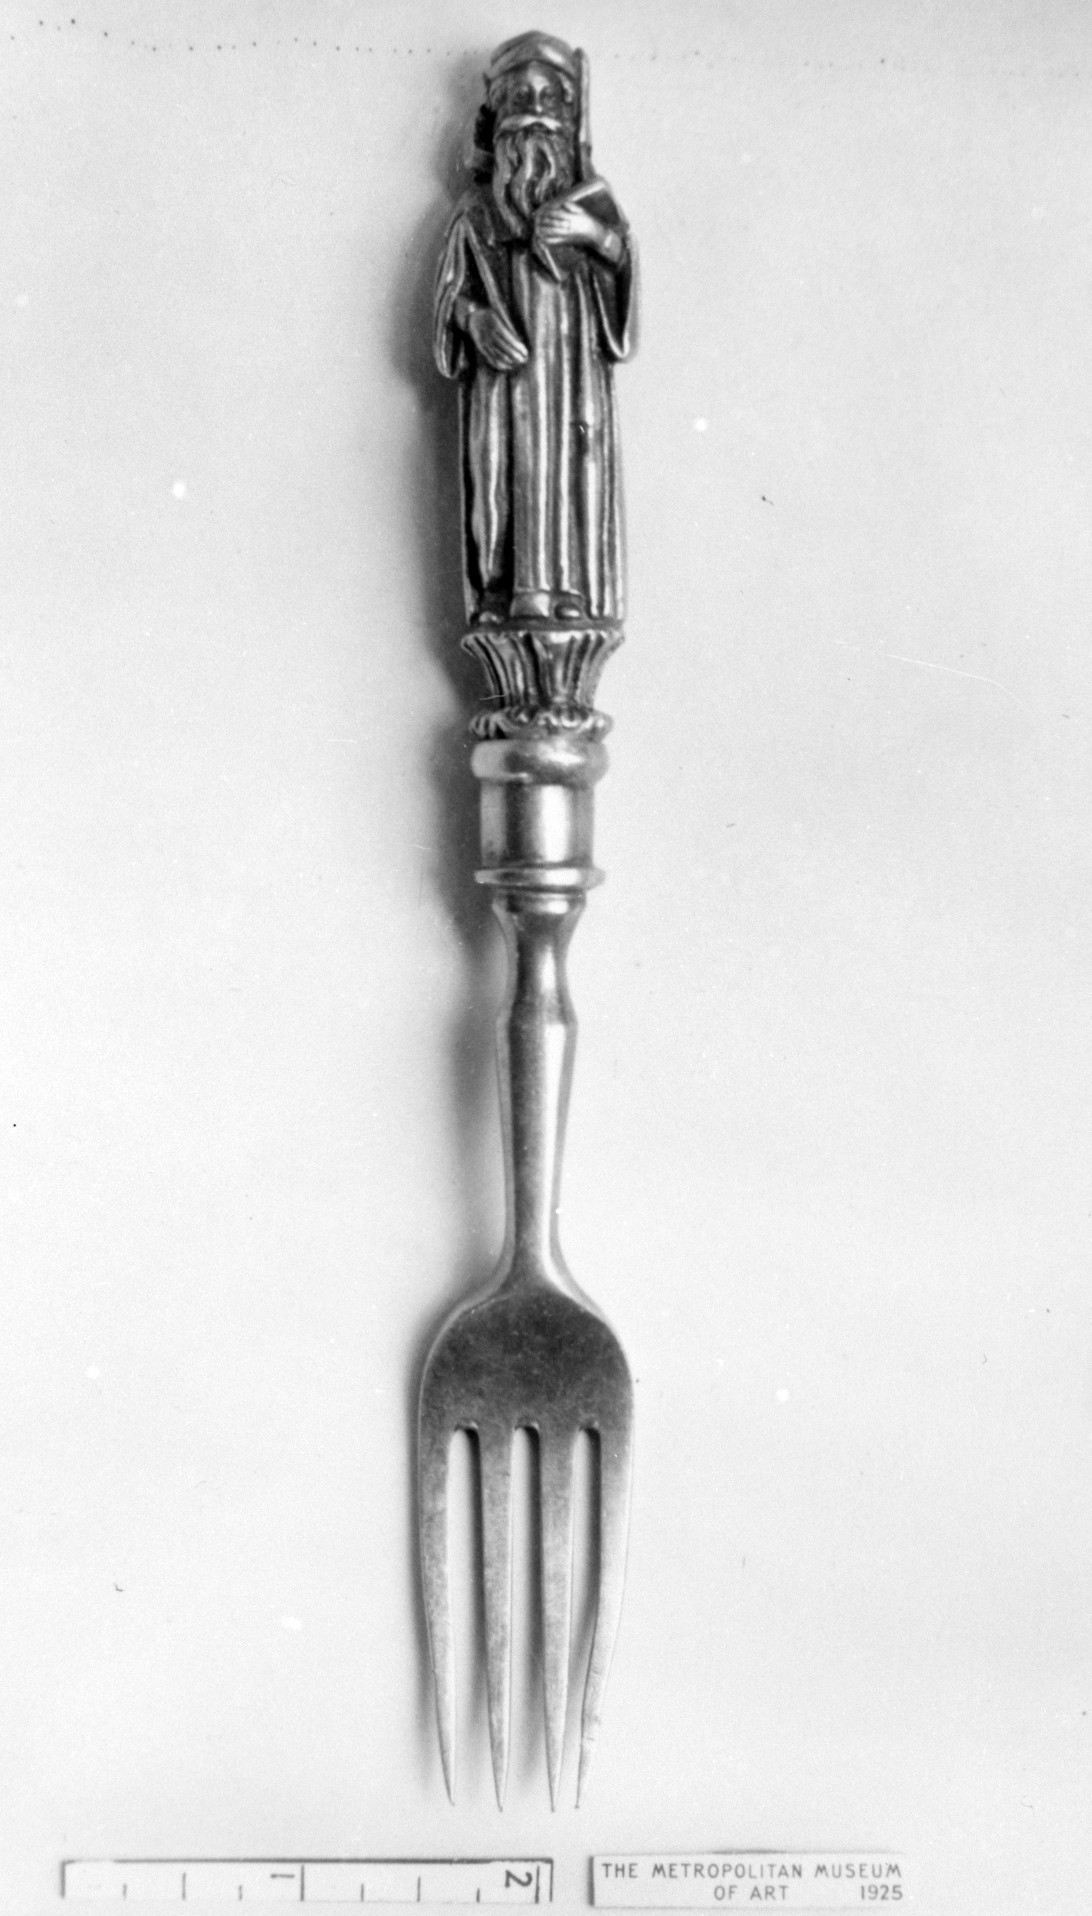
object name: fork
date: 1839-1840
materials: silver gilt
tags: men